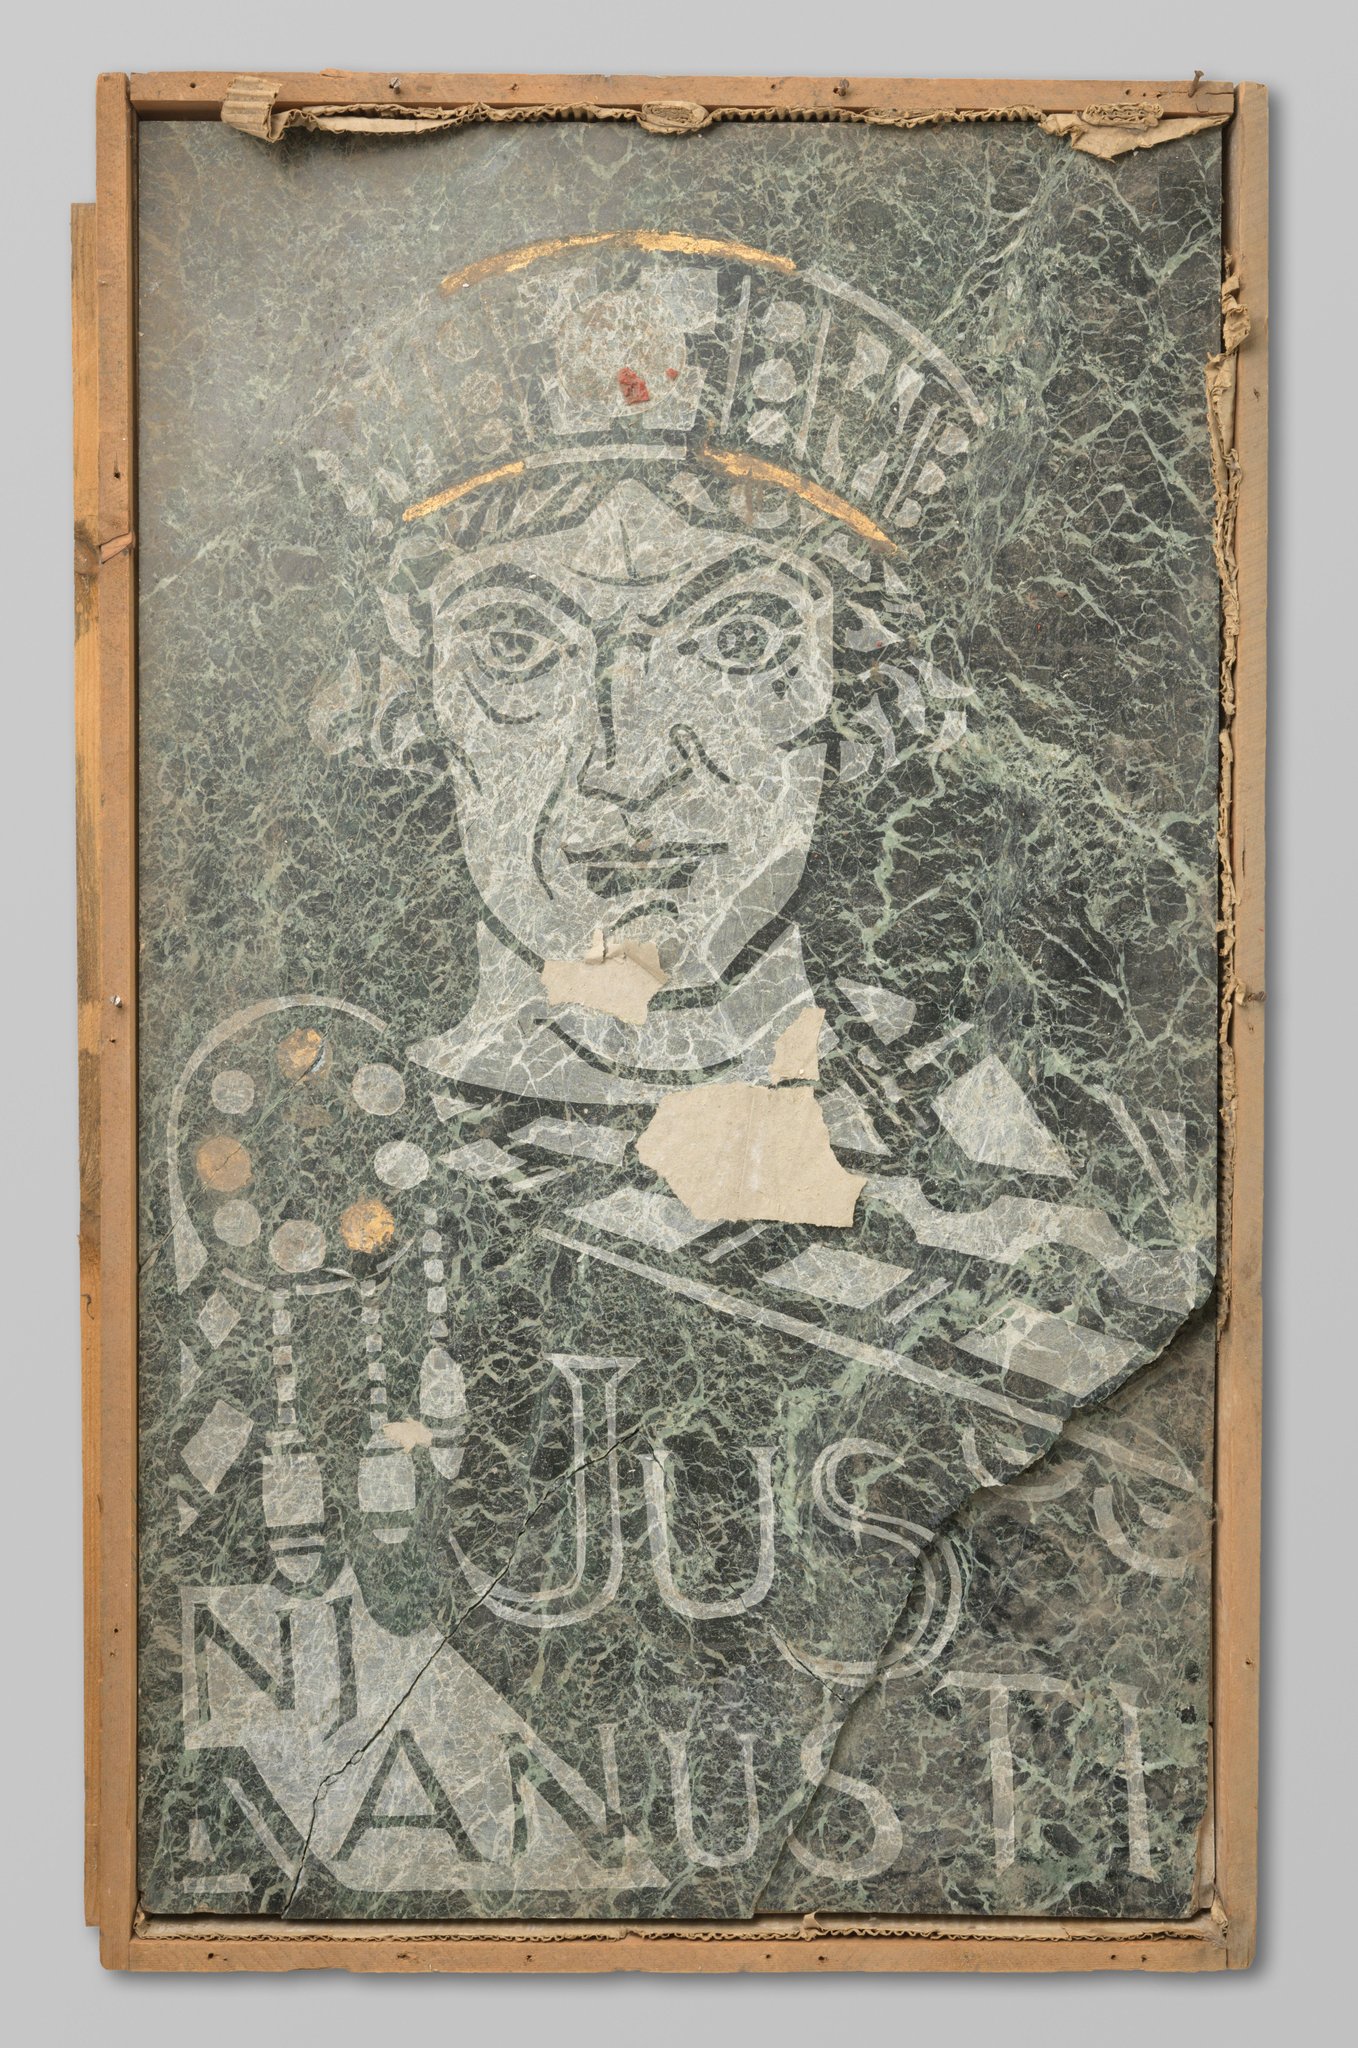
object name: relief sculpture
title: Reliëf voorstellende de persoon van Justinianus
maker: richard nicolaüs roland holst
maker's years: 1868-1938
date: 1936-1938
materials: gold leaf, marble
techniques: sgraffito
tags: the hague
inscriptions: : ‘JUSTINIANUS’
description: Reliëf voorstellende de persoon van Justinianus. Bedoeld voor het gebouw van de Hoge Raad aan het Plein in Den Haag. Onderdeel van een serie van 4 figuren die de grote wetgevers der mensheid moesten verbeelden: Napoleon, Mozes, Solon en Justinianus. Gebouw van de Hoge Raad dateerde uit 1860 en werd bij een verbouwing in 1935- van nieuwe decoraties voorzien. Justinianus uiteindelijk anders uitgevoerd: en face in plaats van frontaal.